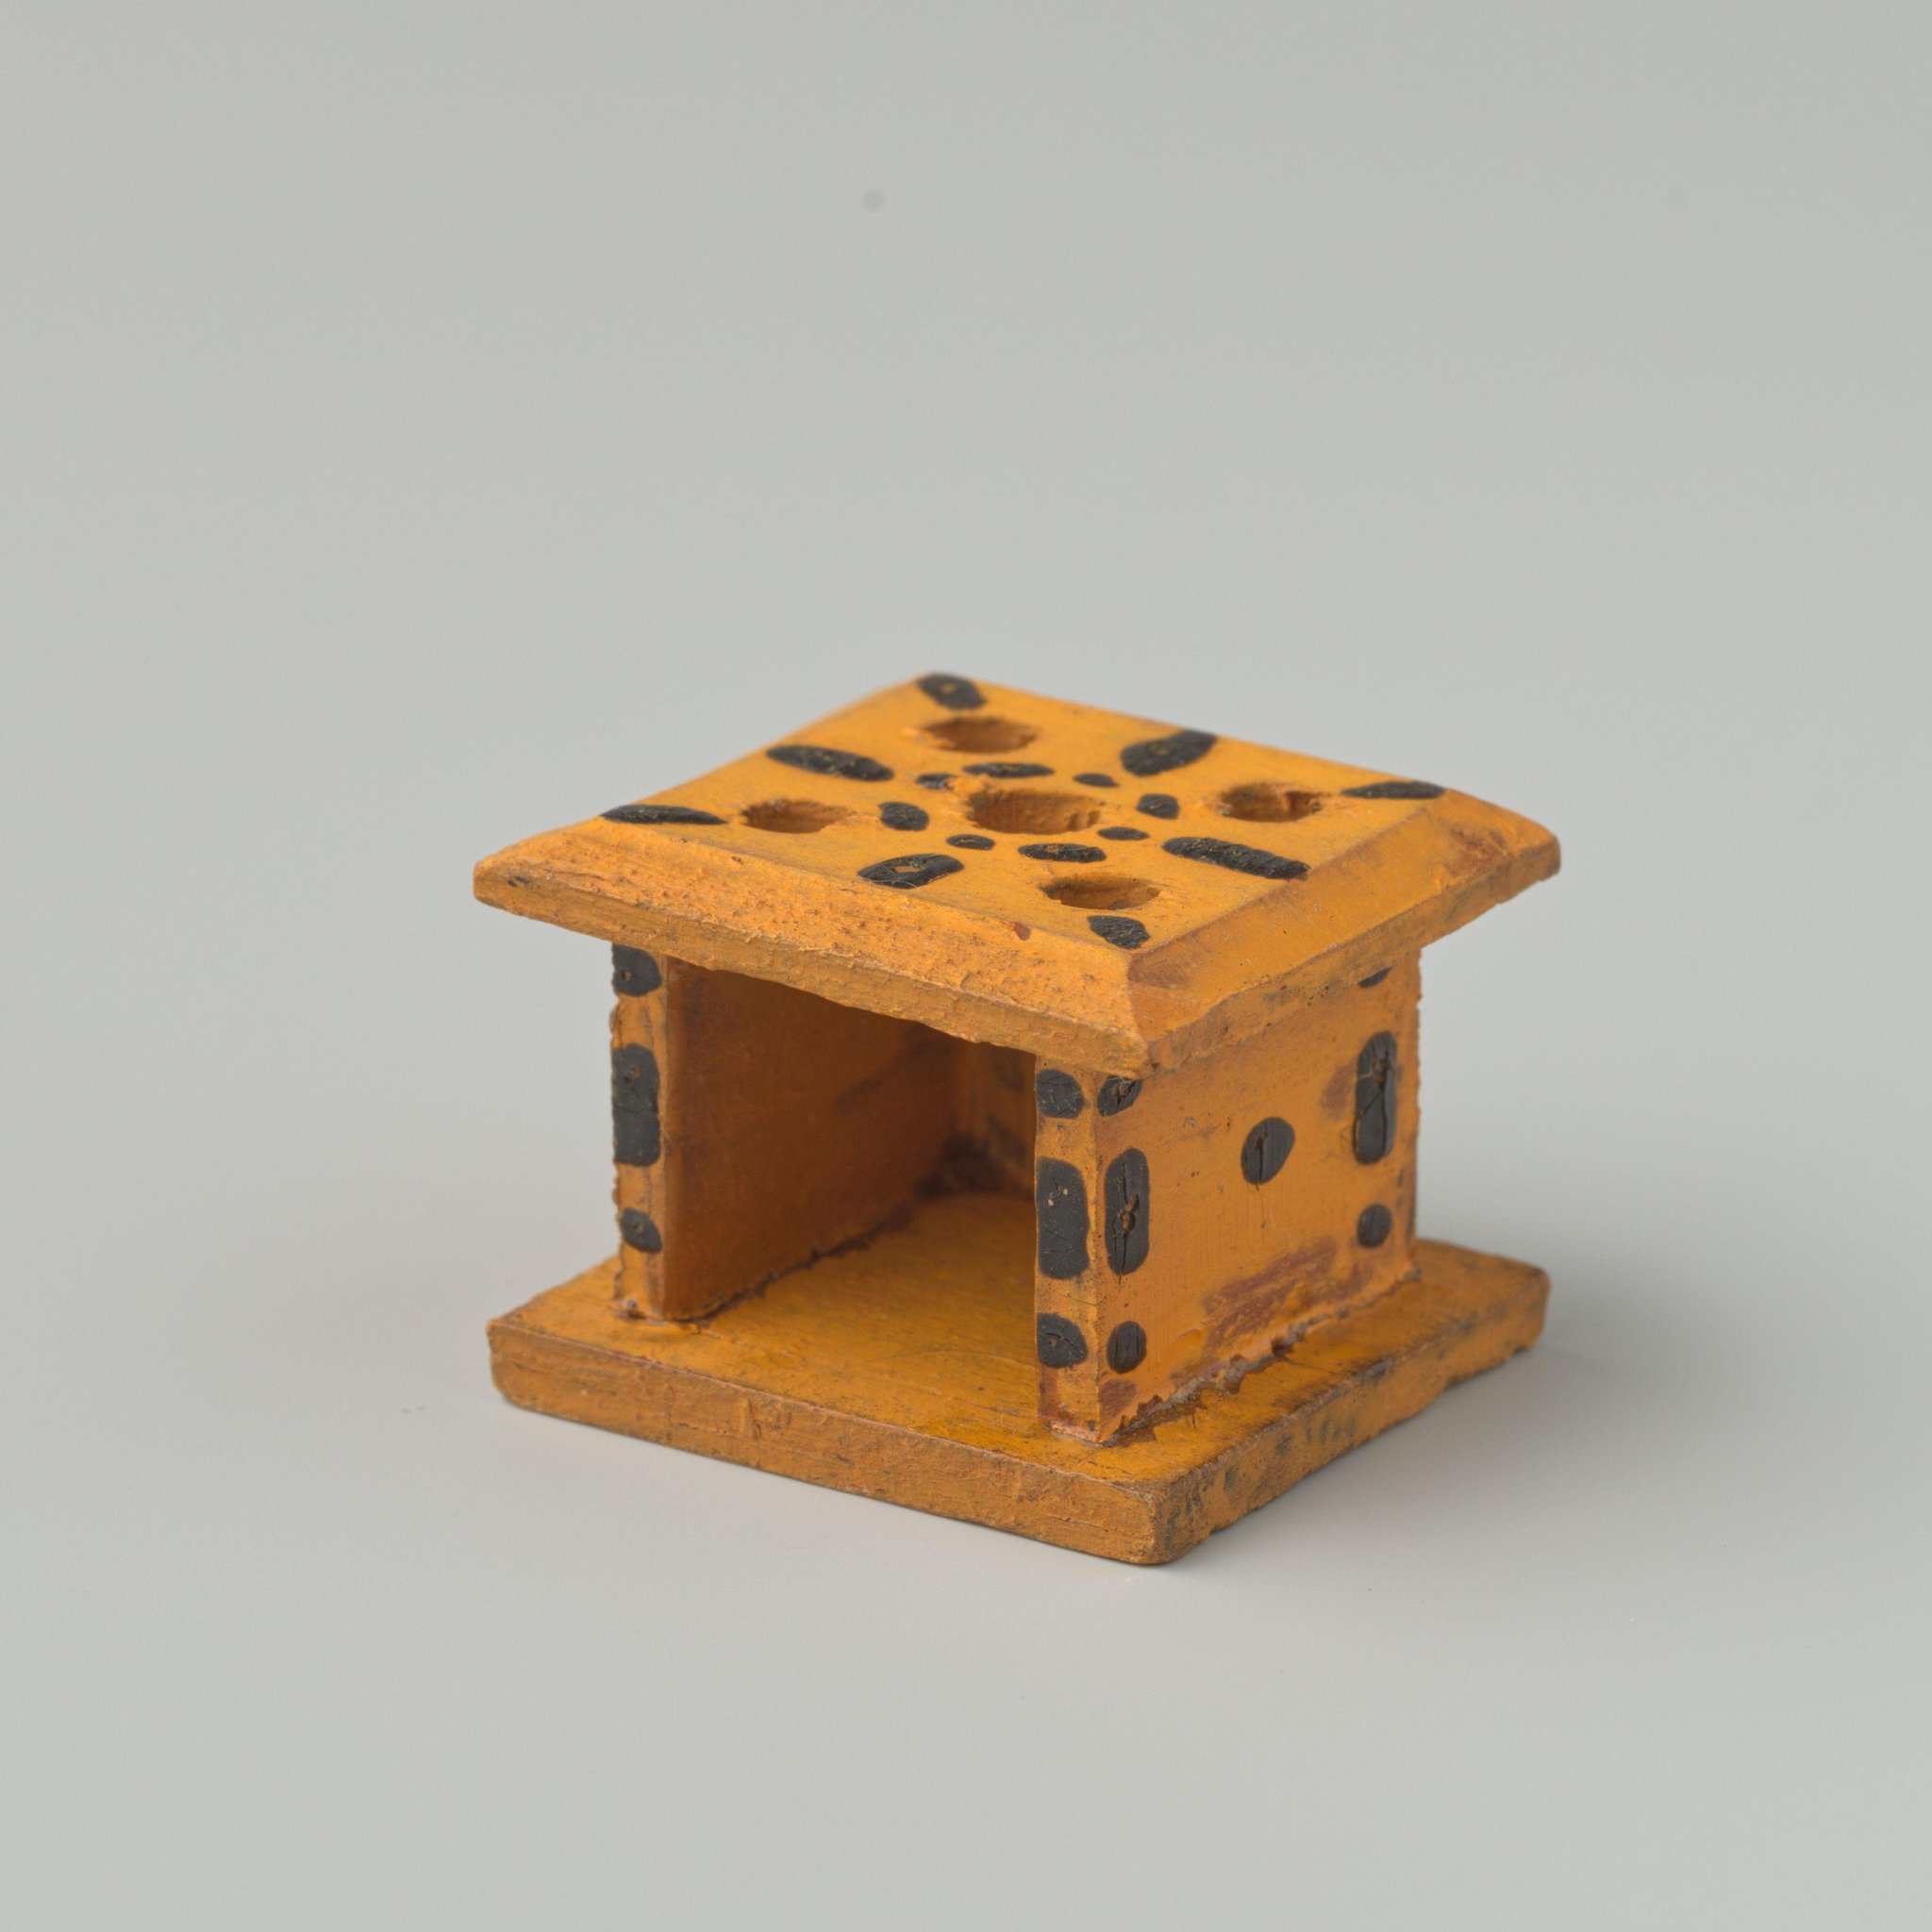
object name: miniature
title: Stoof, geel van kleur, versierd met zwarte stippen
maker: Anonymous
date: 1676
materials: without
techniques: without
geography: amsterdam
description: Stoof van without, vierkant van vorm. De geel gekleurde stoof is versierd met zwarte stippen. In de voetenplank zitten vijf gaten.